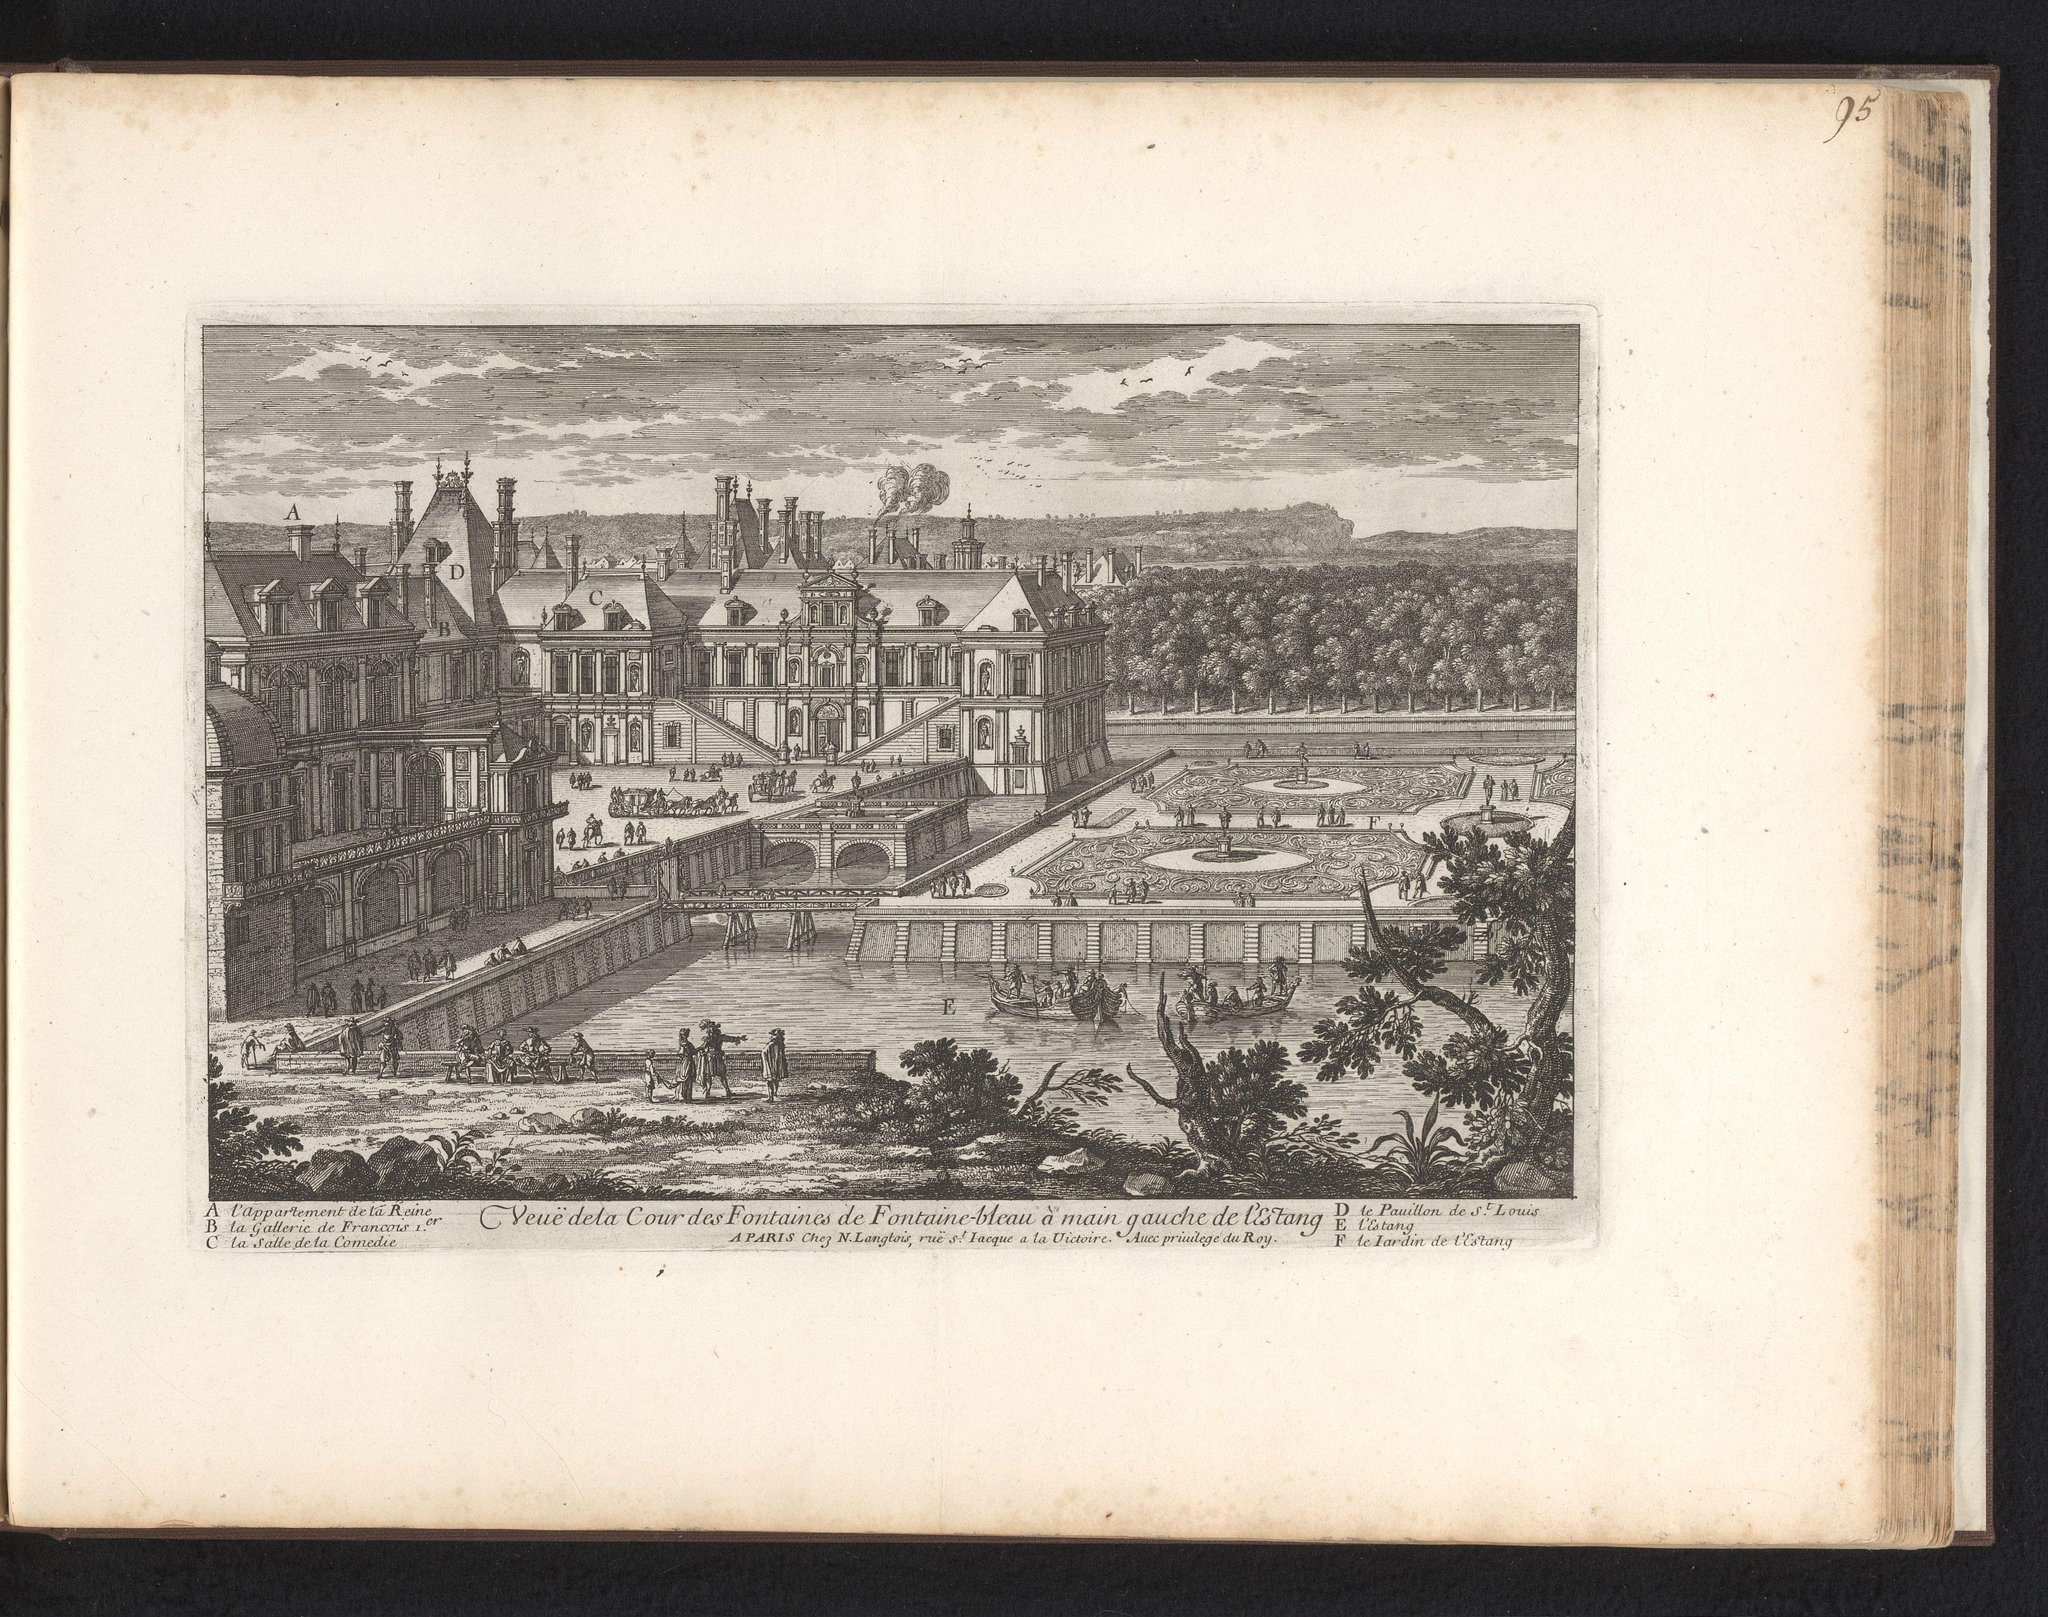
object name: print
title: Recueil de vues de monuments de Paris, des principales résidences royales et des principaux châteaux de France et de Rome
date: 1640-1695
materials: paper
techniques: etching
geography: france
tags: french or architectonic garden; formal garden, landscape with tower or castle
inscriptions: collector's mark: Lugt 2228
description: Prenten met het signatuur 'Perelle' kunnen zowel door vader Gabriel als door zonen Nicolas en Adam gemaakt zijn. De uitgevers vader en zoon Nicolas Langlois worden allebei vermeld als N. Langlois op hetzelfde adres.